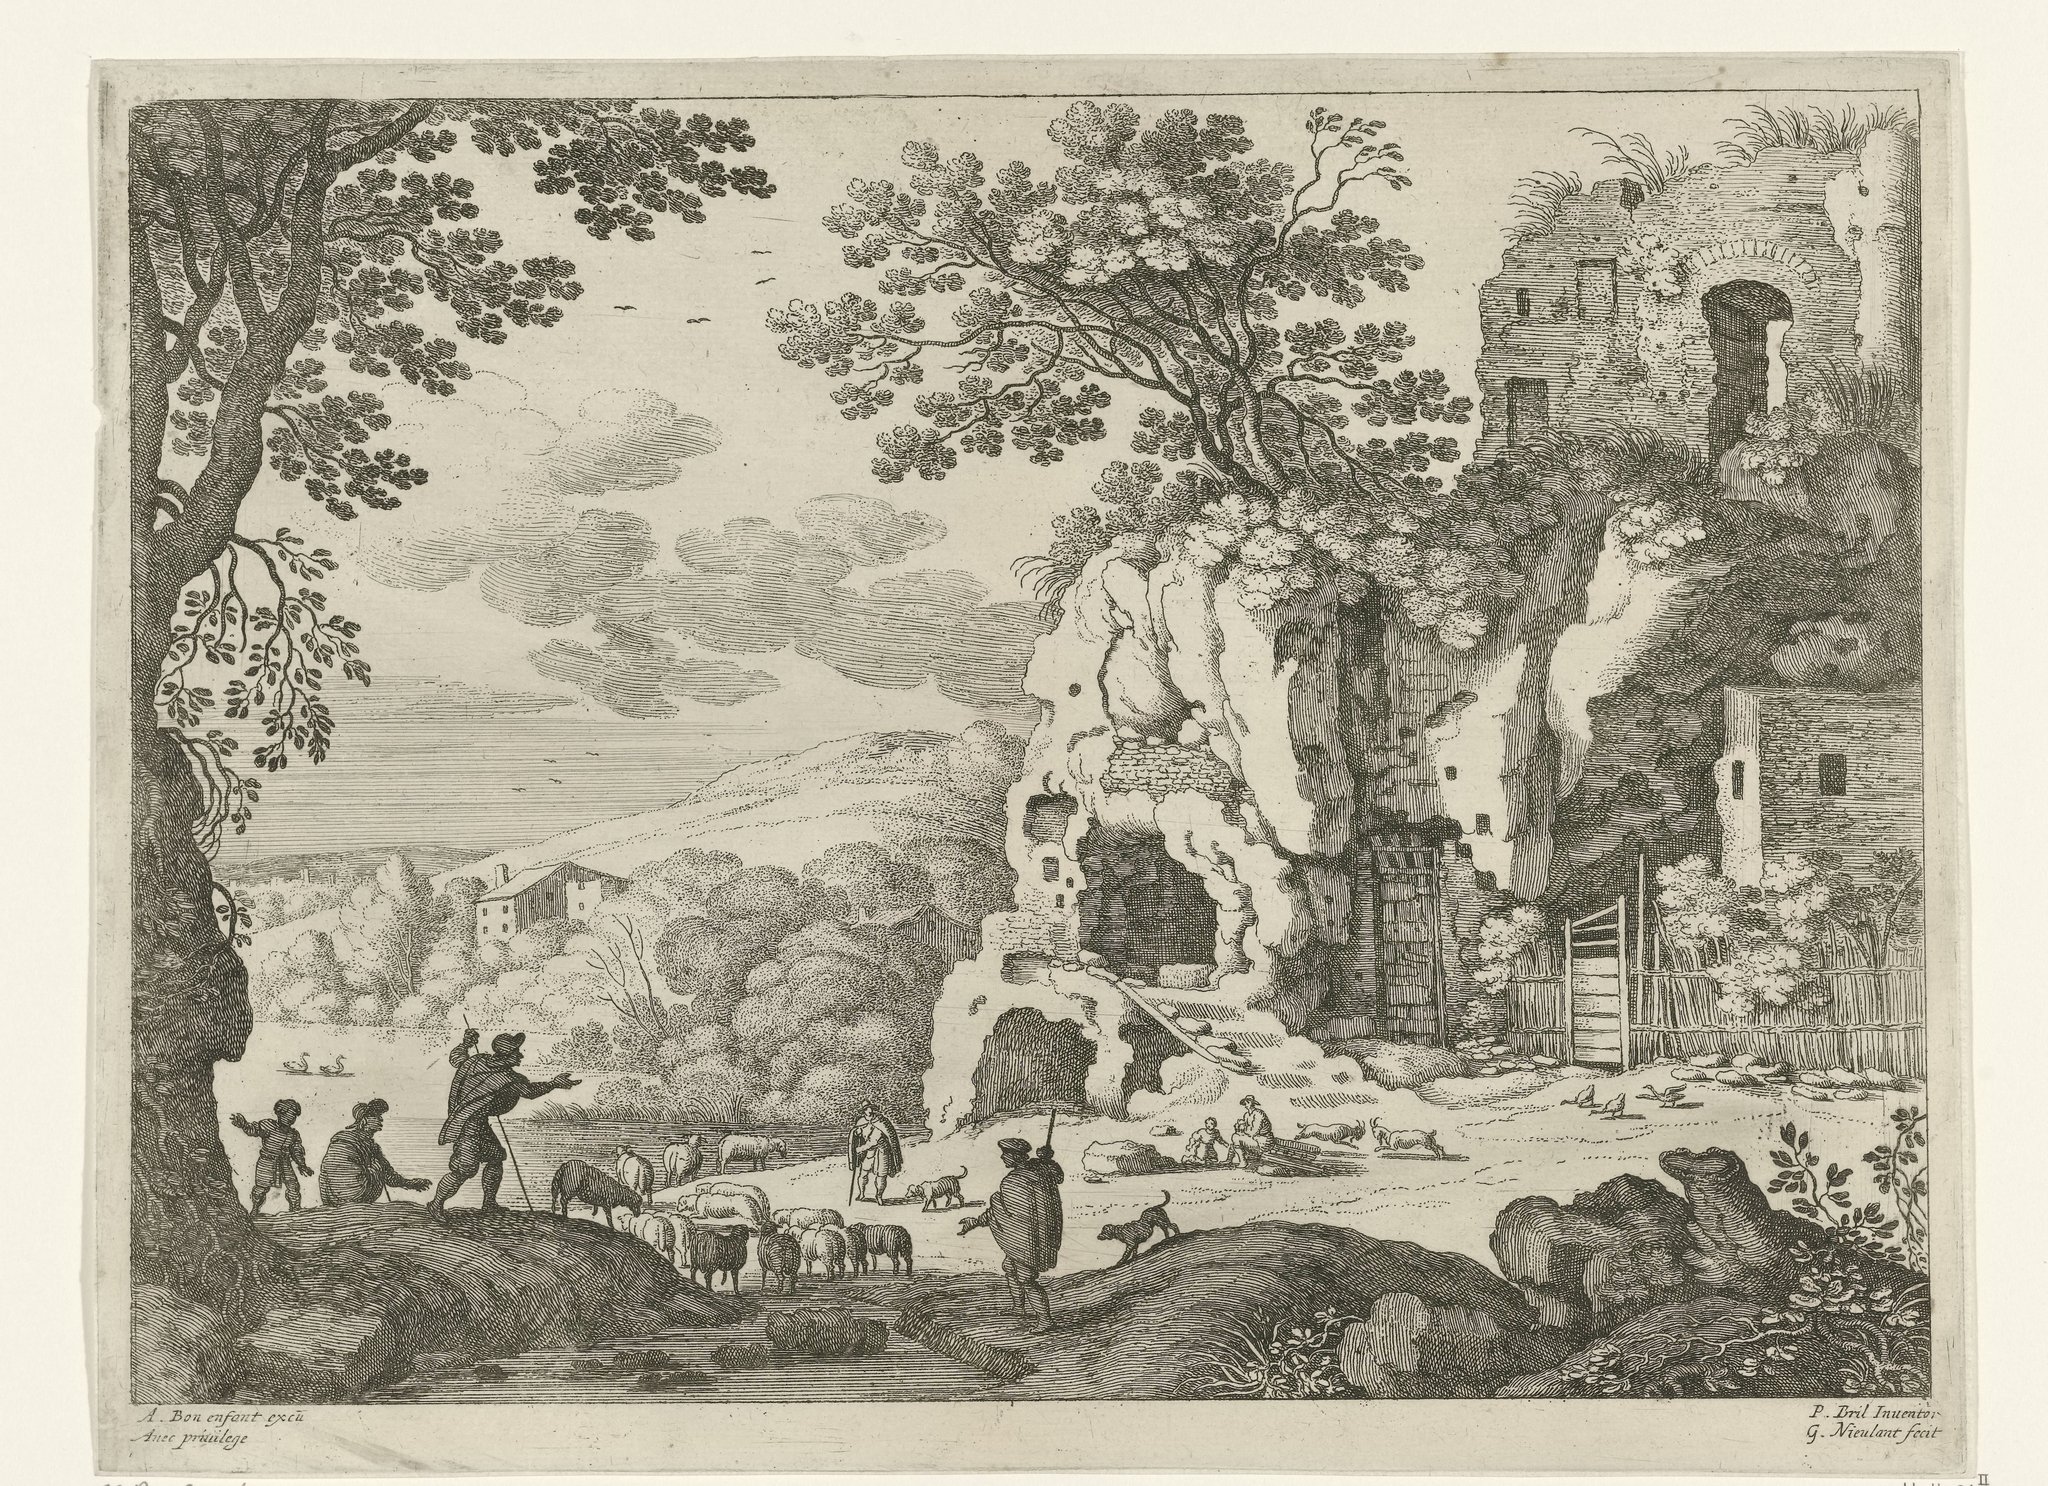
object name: print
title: Landschap met een ruïne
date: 1594-1635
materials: paper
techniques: engraving, etching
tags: herding, herdsman, herdswoman, shepherd, shepherdess, cowherd, etc., landscape with ruins, lake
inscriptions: collector's mark: Lugt 240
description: Voor een ruïne op een rots lopen verschillende herders met schapen en honden. Links op de achtergrond een meer. Prent uit een serie Italiaanse landschappen.